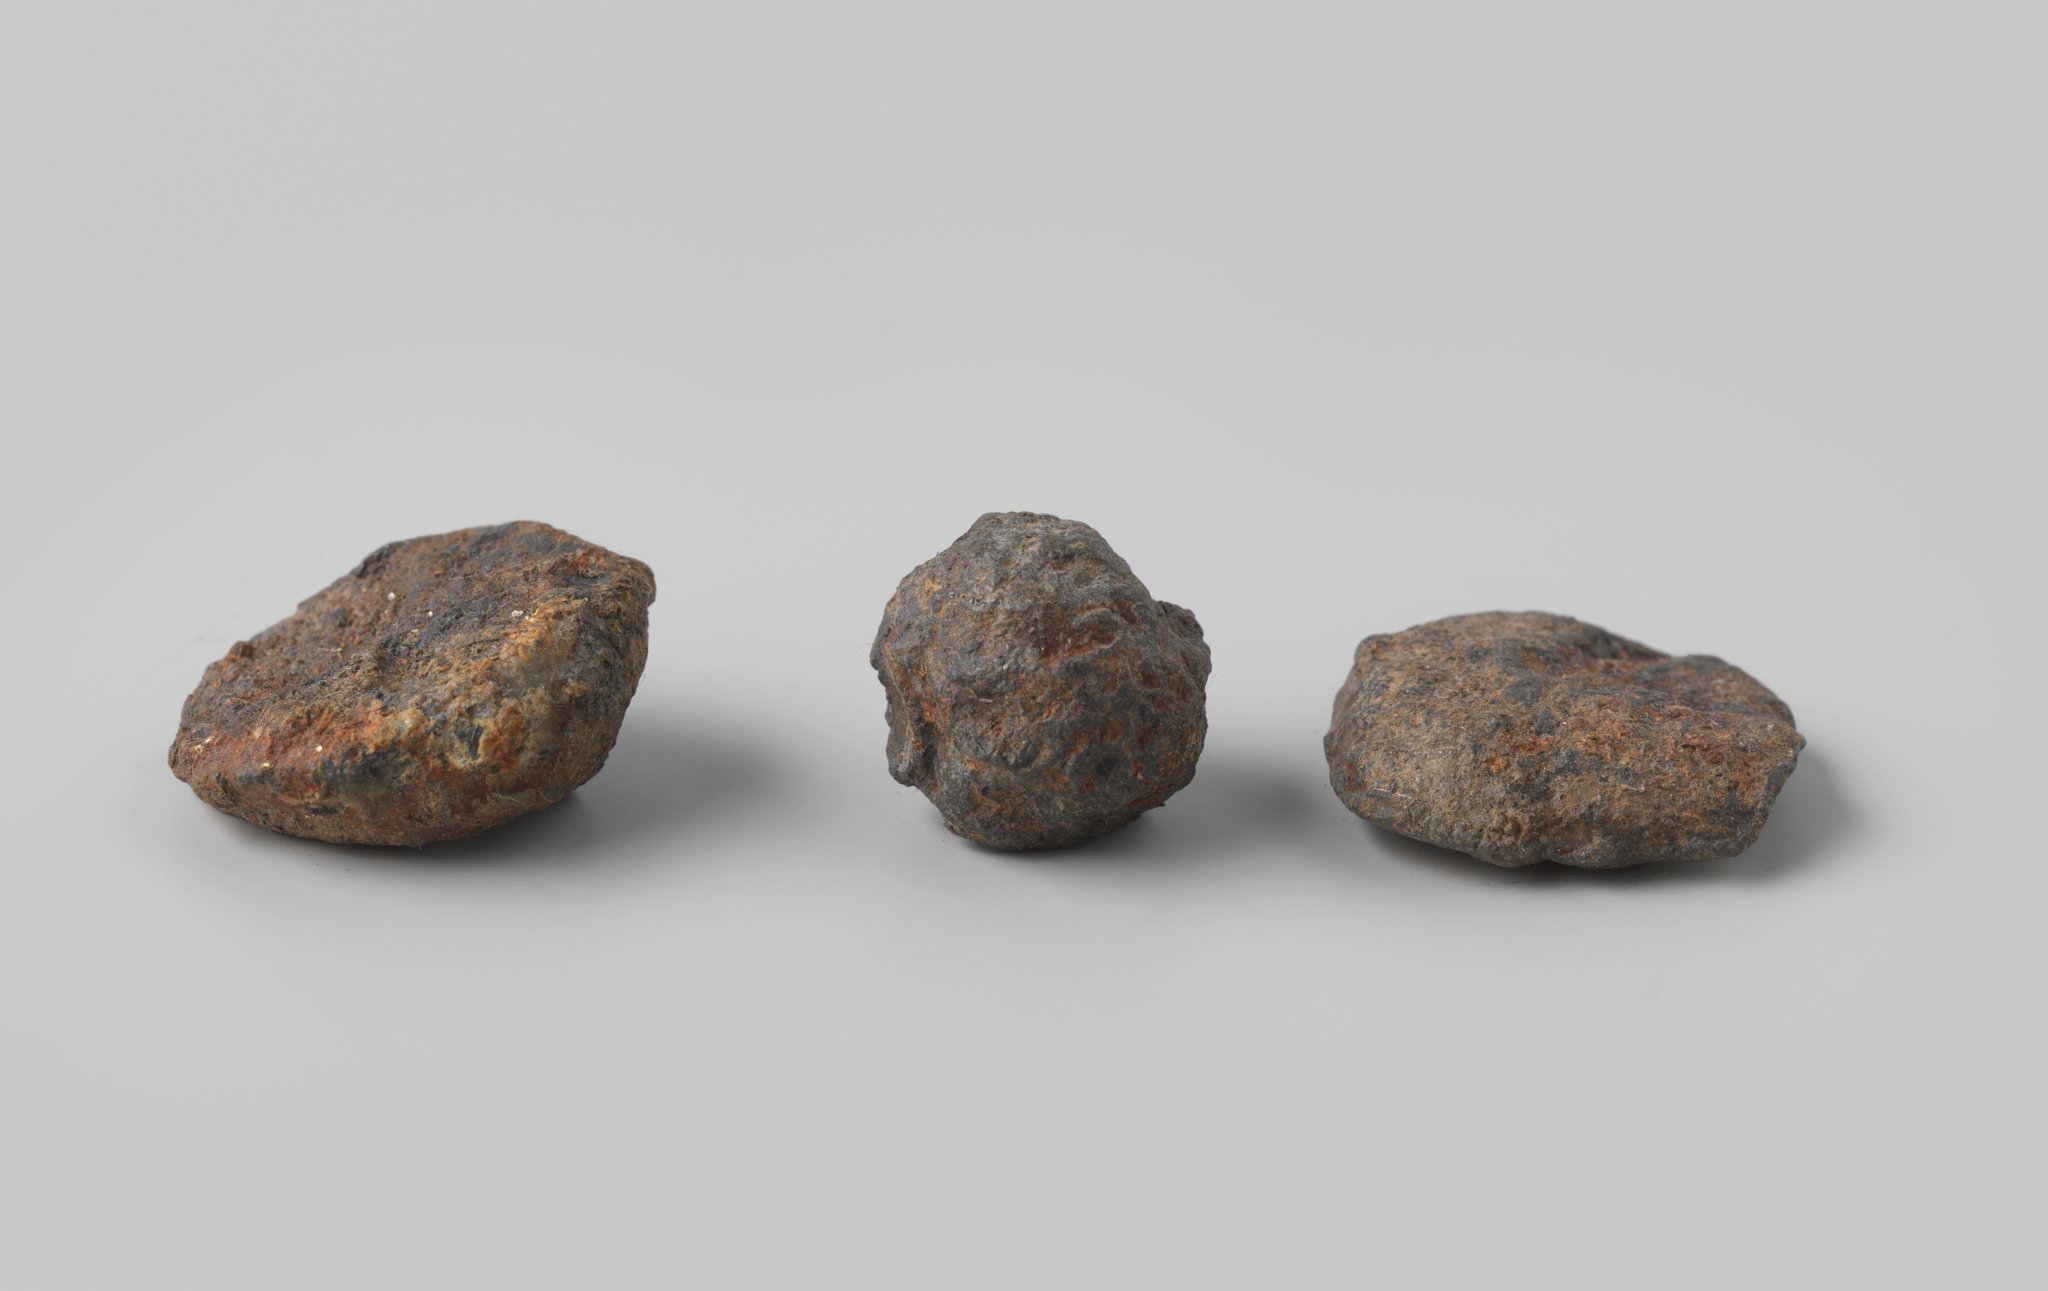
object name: musketkogel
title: Musketkogels uit het wrak van de Oost-Indiëvaarder Hollandia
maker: Anonymous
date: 1700-1743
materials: lead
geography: netherlands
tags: verenigde oostindische compagnie, hollandia (schip), annet